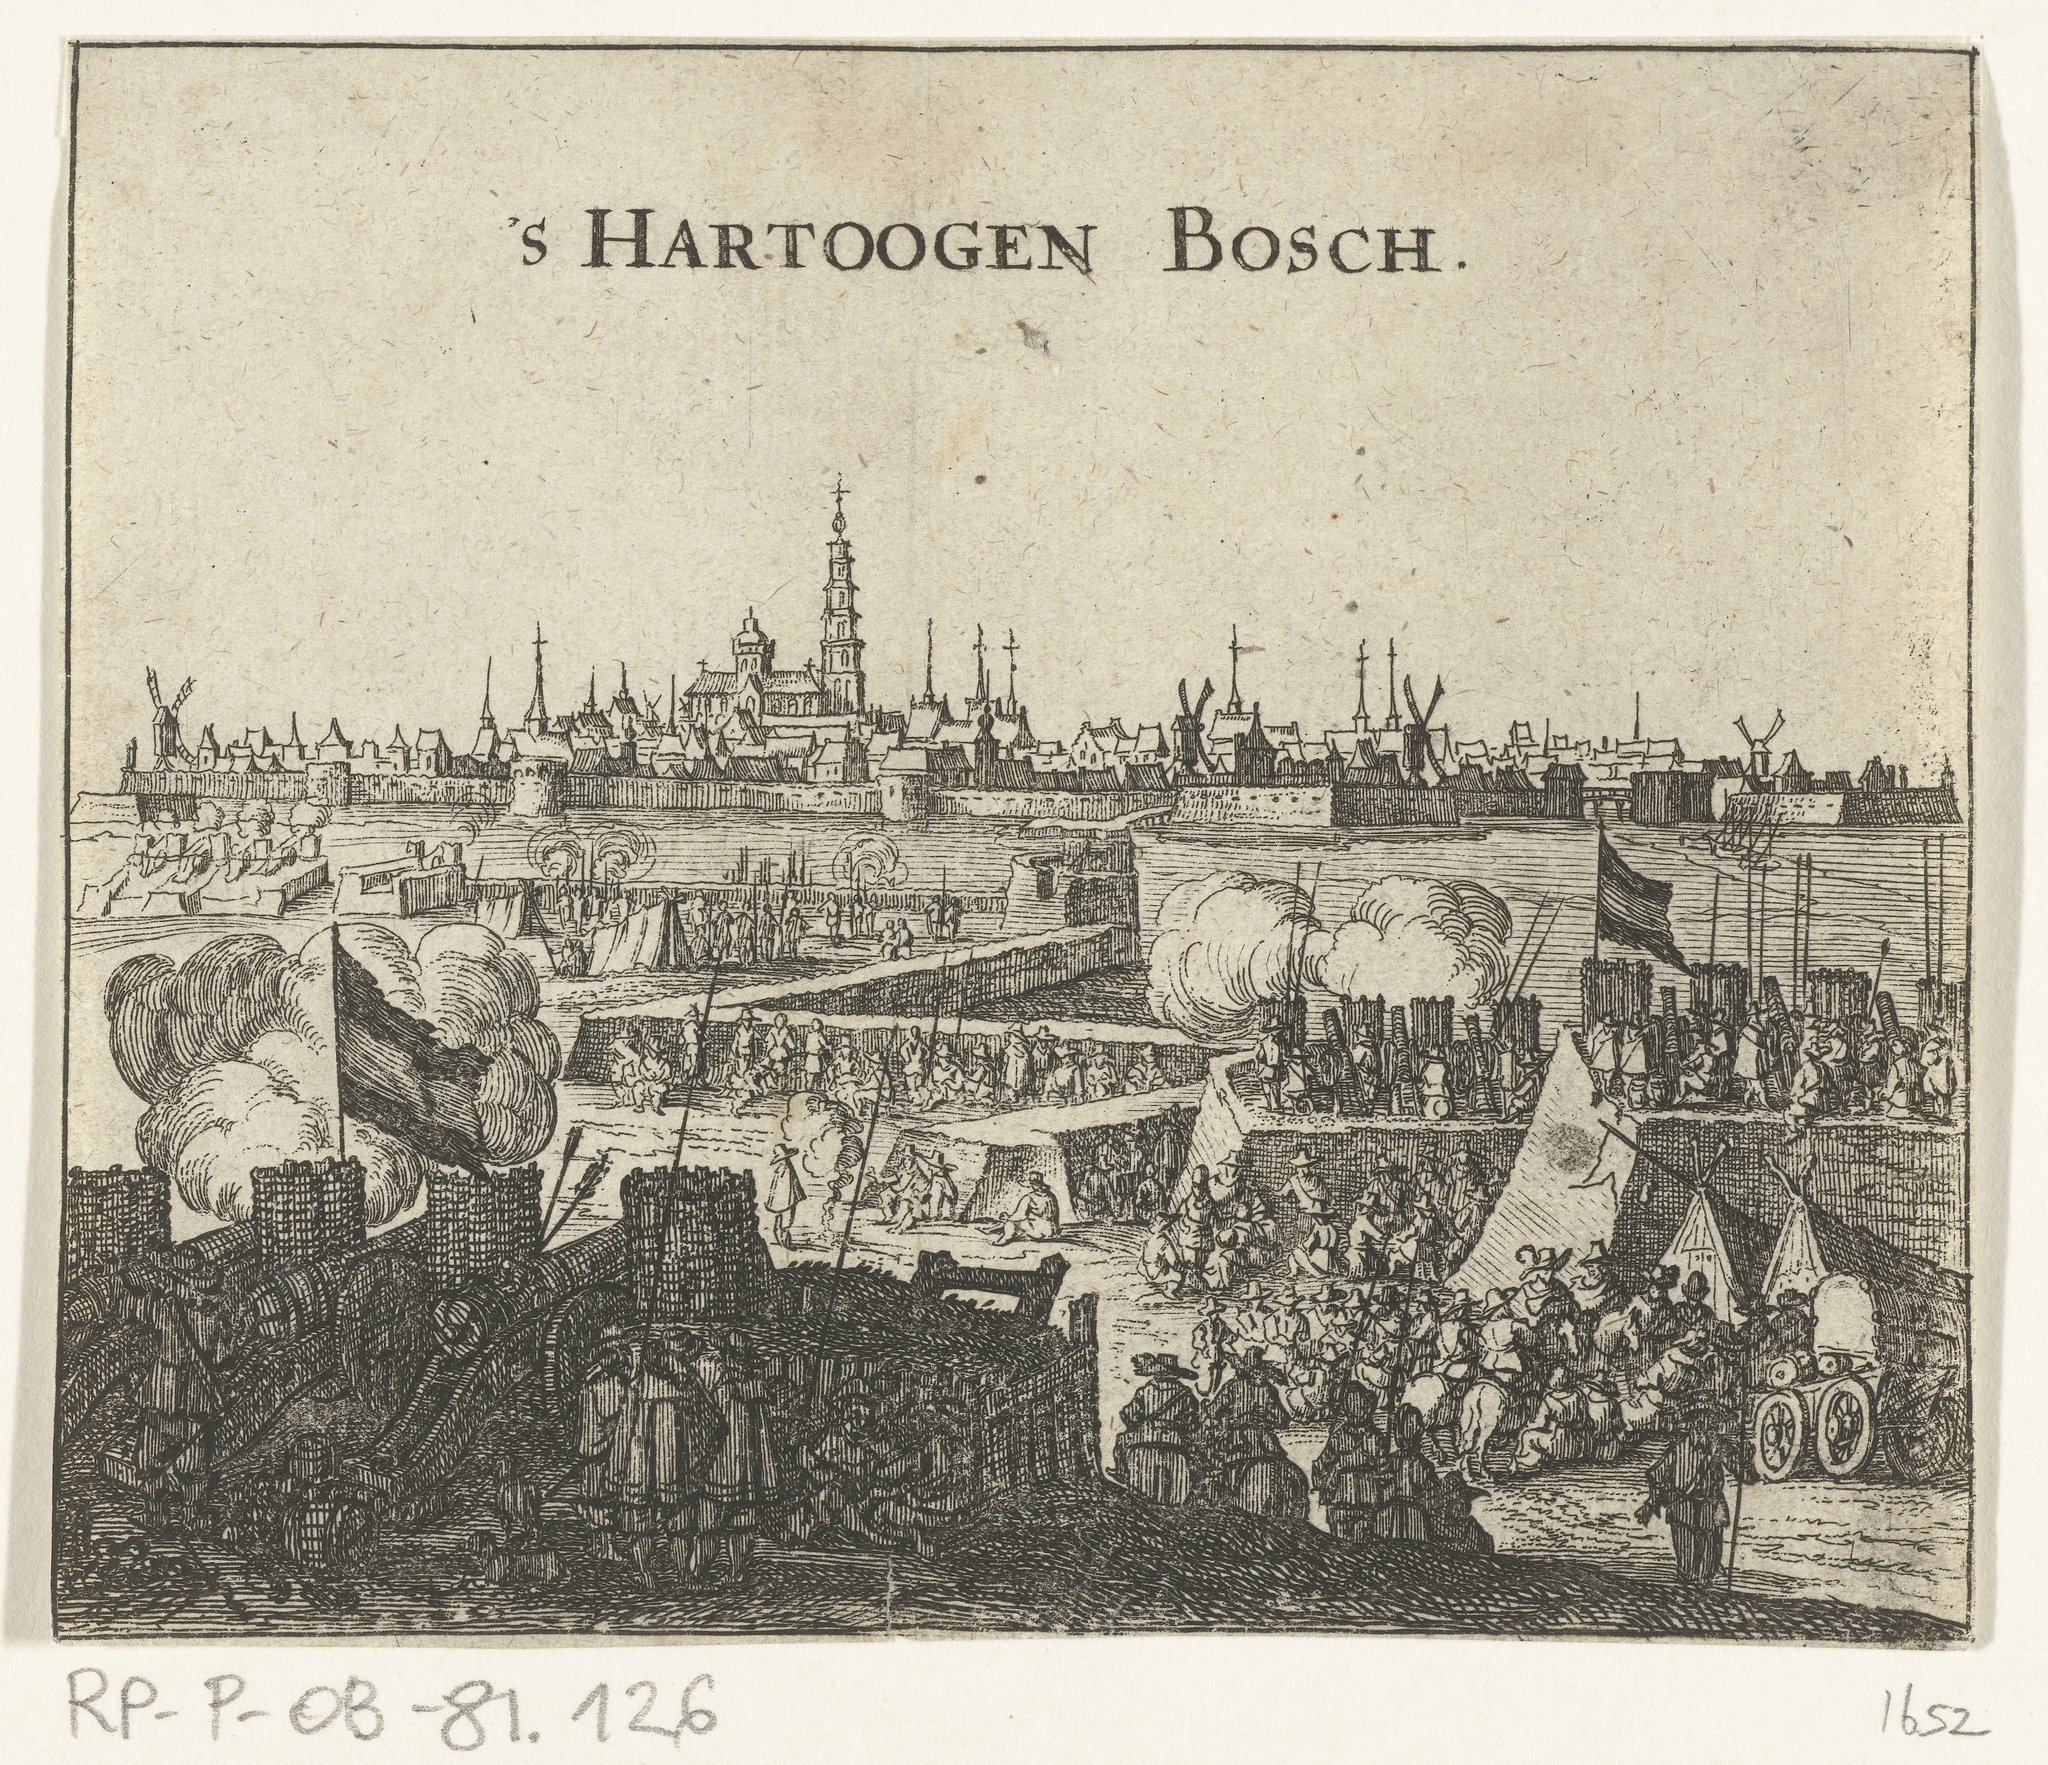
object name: history print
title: 's Hartoogen Bosch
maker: Anonymous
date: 1650-1652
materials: paper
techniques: etching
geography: northern netherlands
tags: the hague, frederick henry (prince of orange), siege, position war, den bosch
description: Beleg van 's-Hertogenbosch door het Staatse leger onder Frederik Hendrik, mei tot september 1629. Gezicht op de versterkte stad vanuit de positie van het belegerende Staatse leger. Het paginanummer 249 weggepolijst.